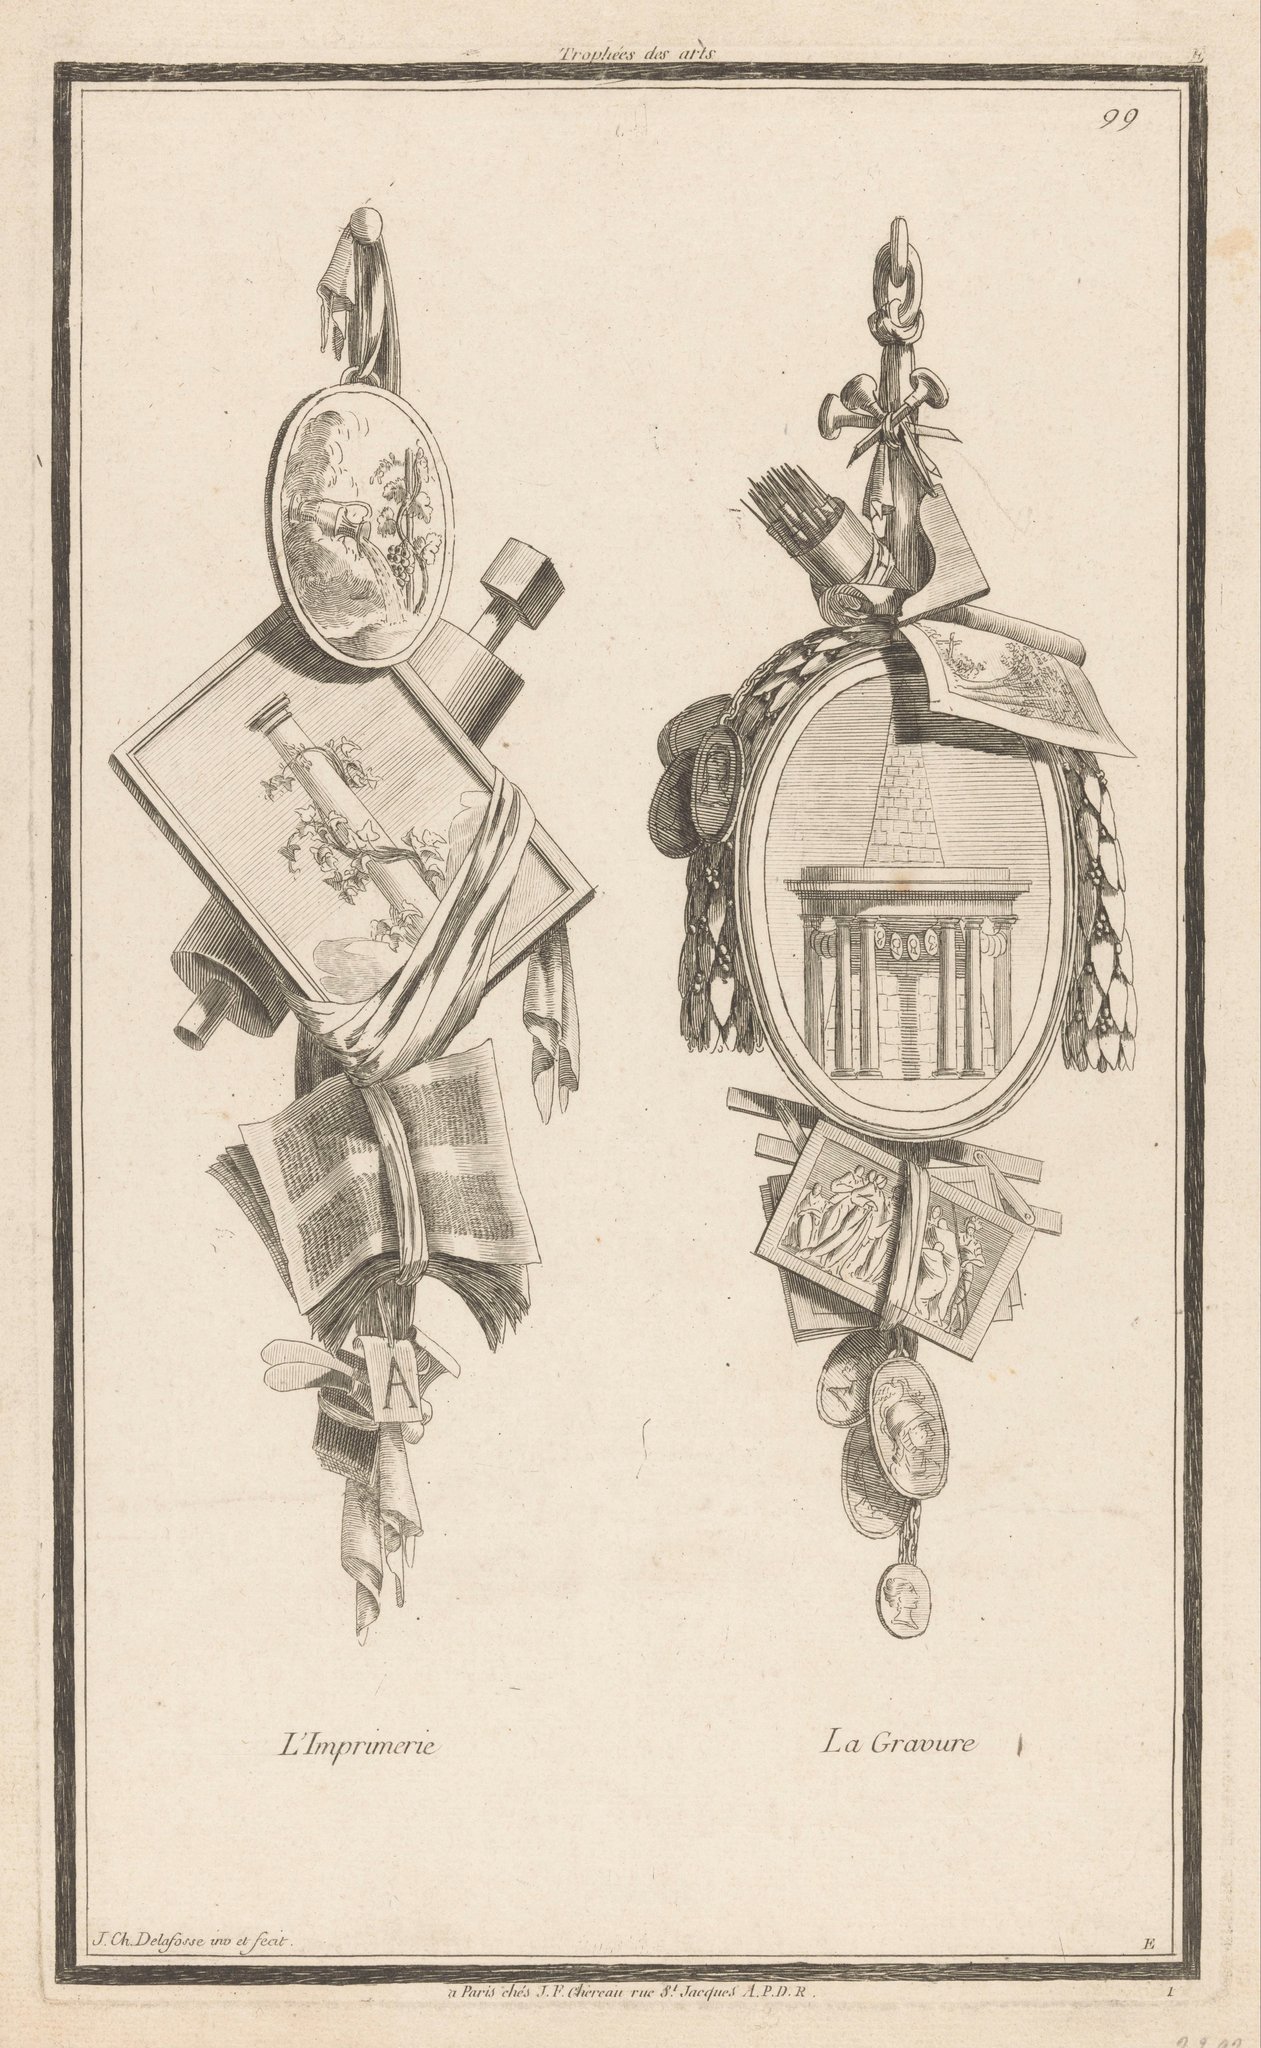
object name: ornament print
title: L'Imprimerie, La Gravure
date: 1768-1771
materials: paper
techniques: engraving, etching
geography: paris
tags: trophy, i.e.: decorative arrangement of symbolic or typical objects ~ ornament, the graphic arts, production of printed matter, book-production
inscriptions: collector's mark: Lugt 2228, collector's mark: Lugt 2760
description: Links een trofee met attributen behorende bij boekdrukkunst en een lijst met een door ranken omhulde zuil. Rechts een trofee met attributen behorende bij grafiek en een lijst met een obelisk omringd door zuilen. Prentnummer 99.